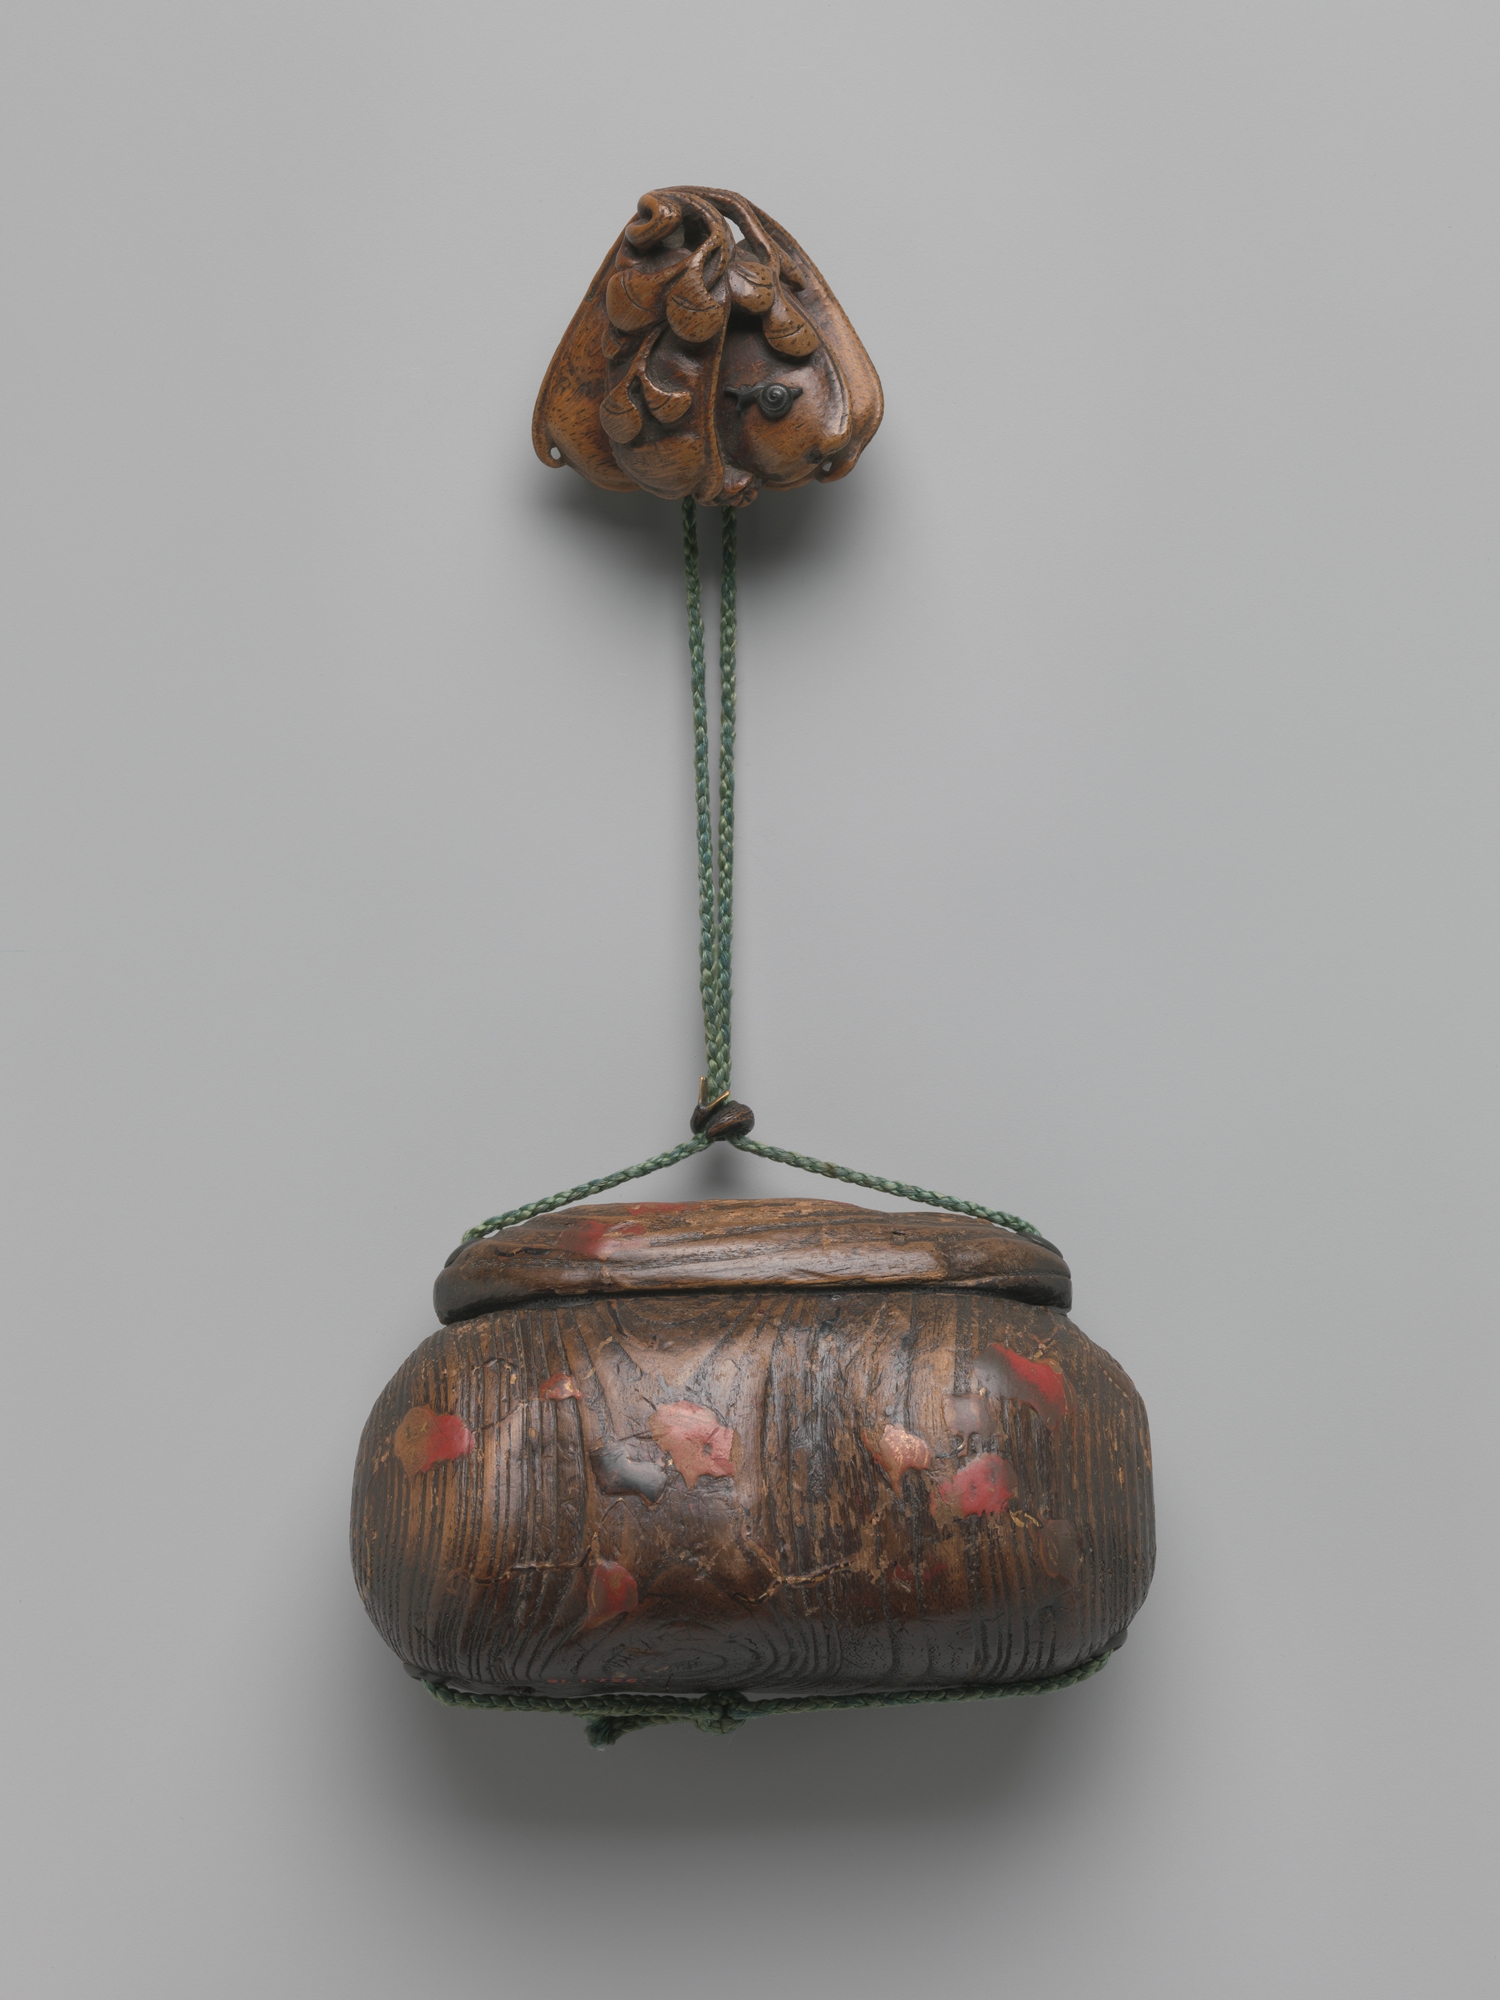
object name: tobacco pouch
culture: japanese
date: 1850-1880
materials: lacquer